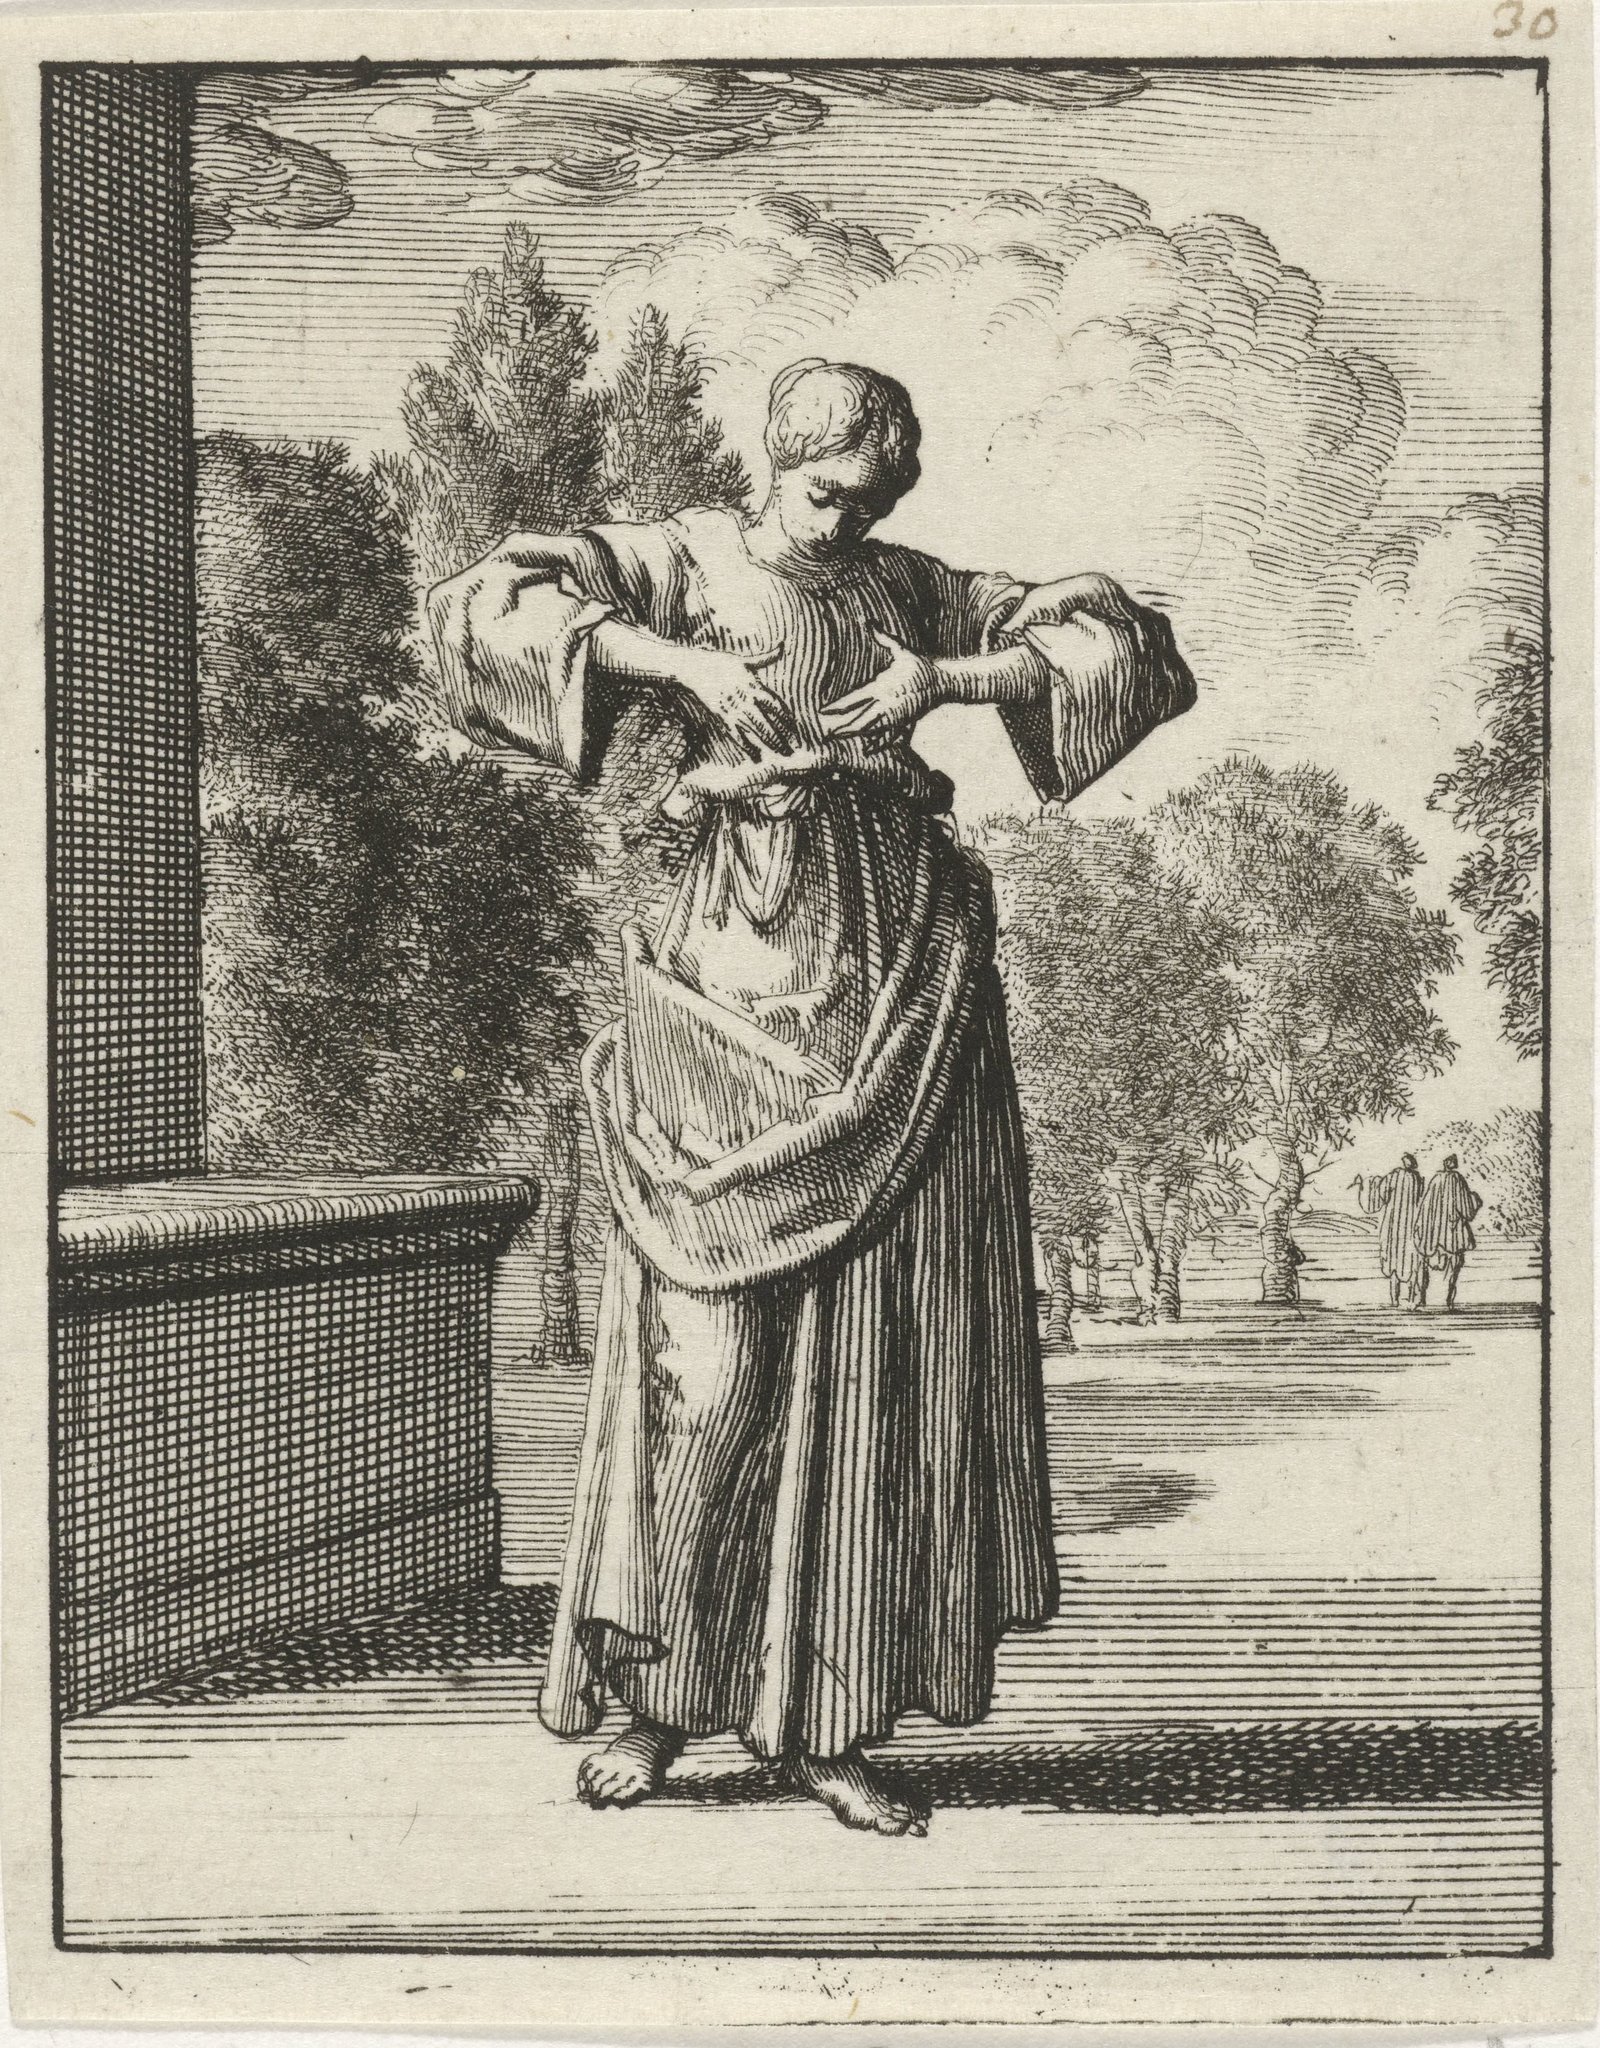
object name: book illustration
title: Vrouw betast haar eigen boezem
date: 1687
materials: paper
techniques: etching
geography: amsterdam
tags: breasts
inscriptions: number: ‘30’, collector's mark: Lugt 2228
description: Illustratie uit: Luyken, Jan. Voncken der liefde Jesu, van het godtbegerende zielenvier. Amsterdam: Pieter Arentsz (II), 1687, p. 124.